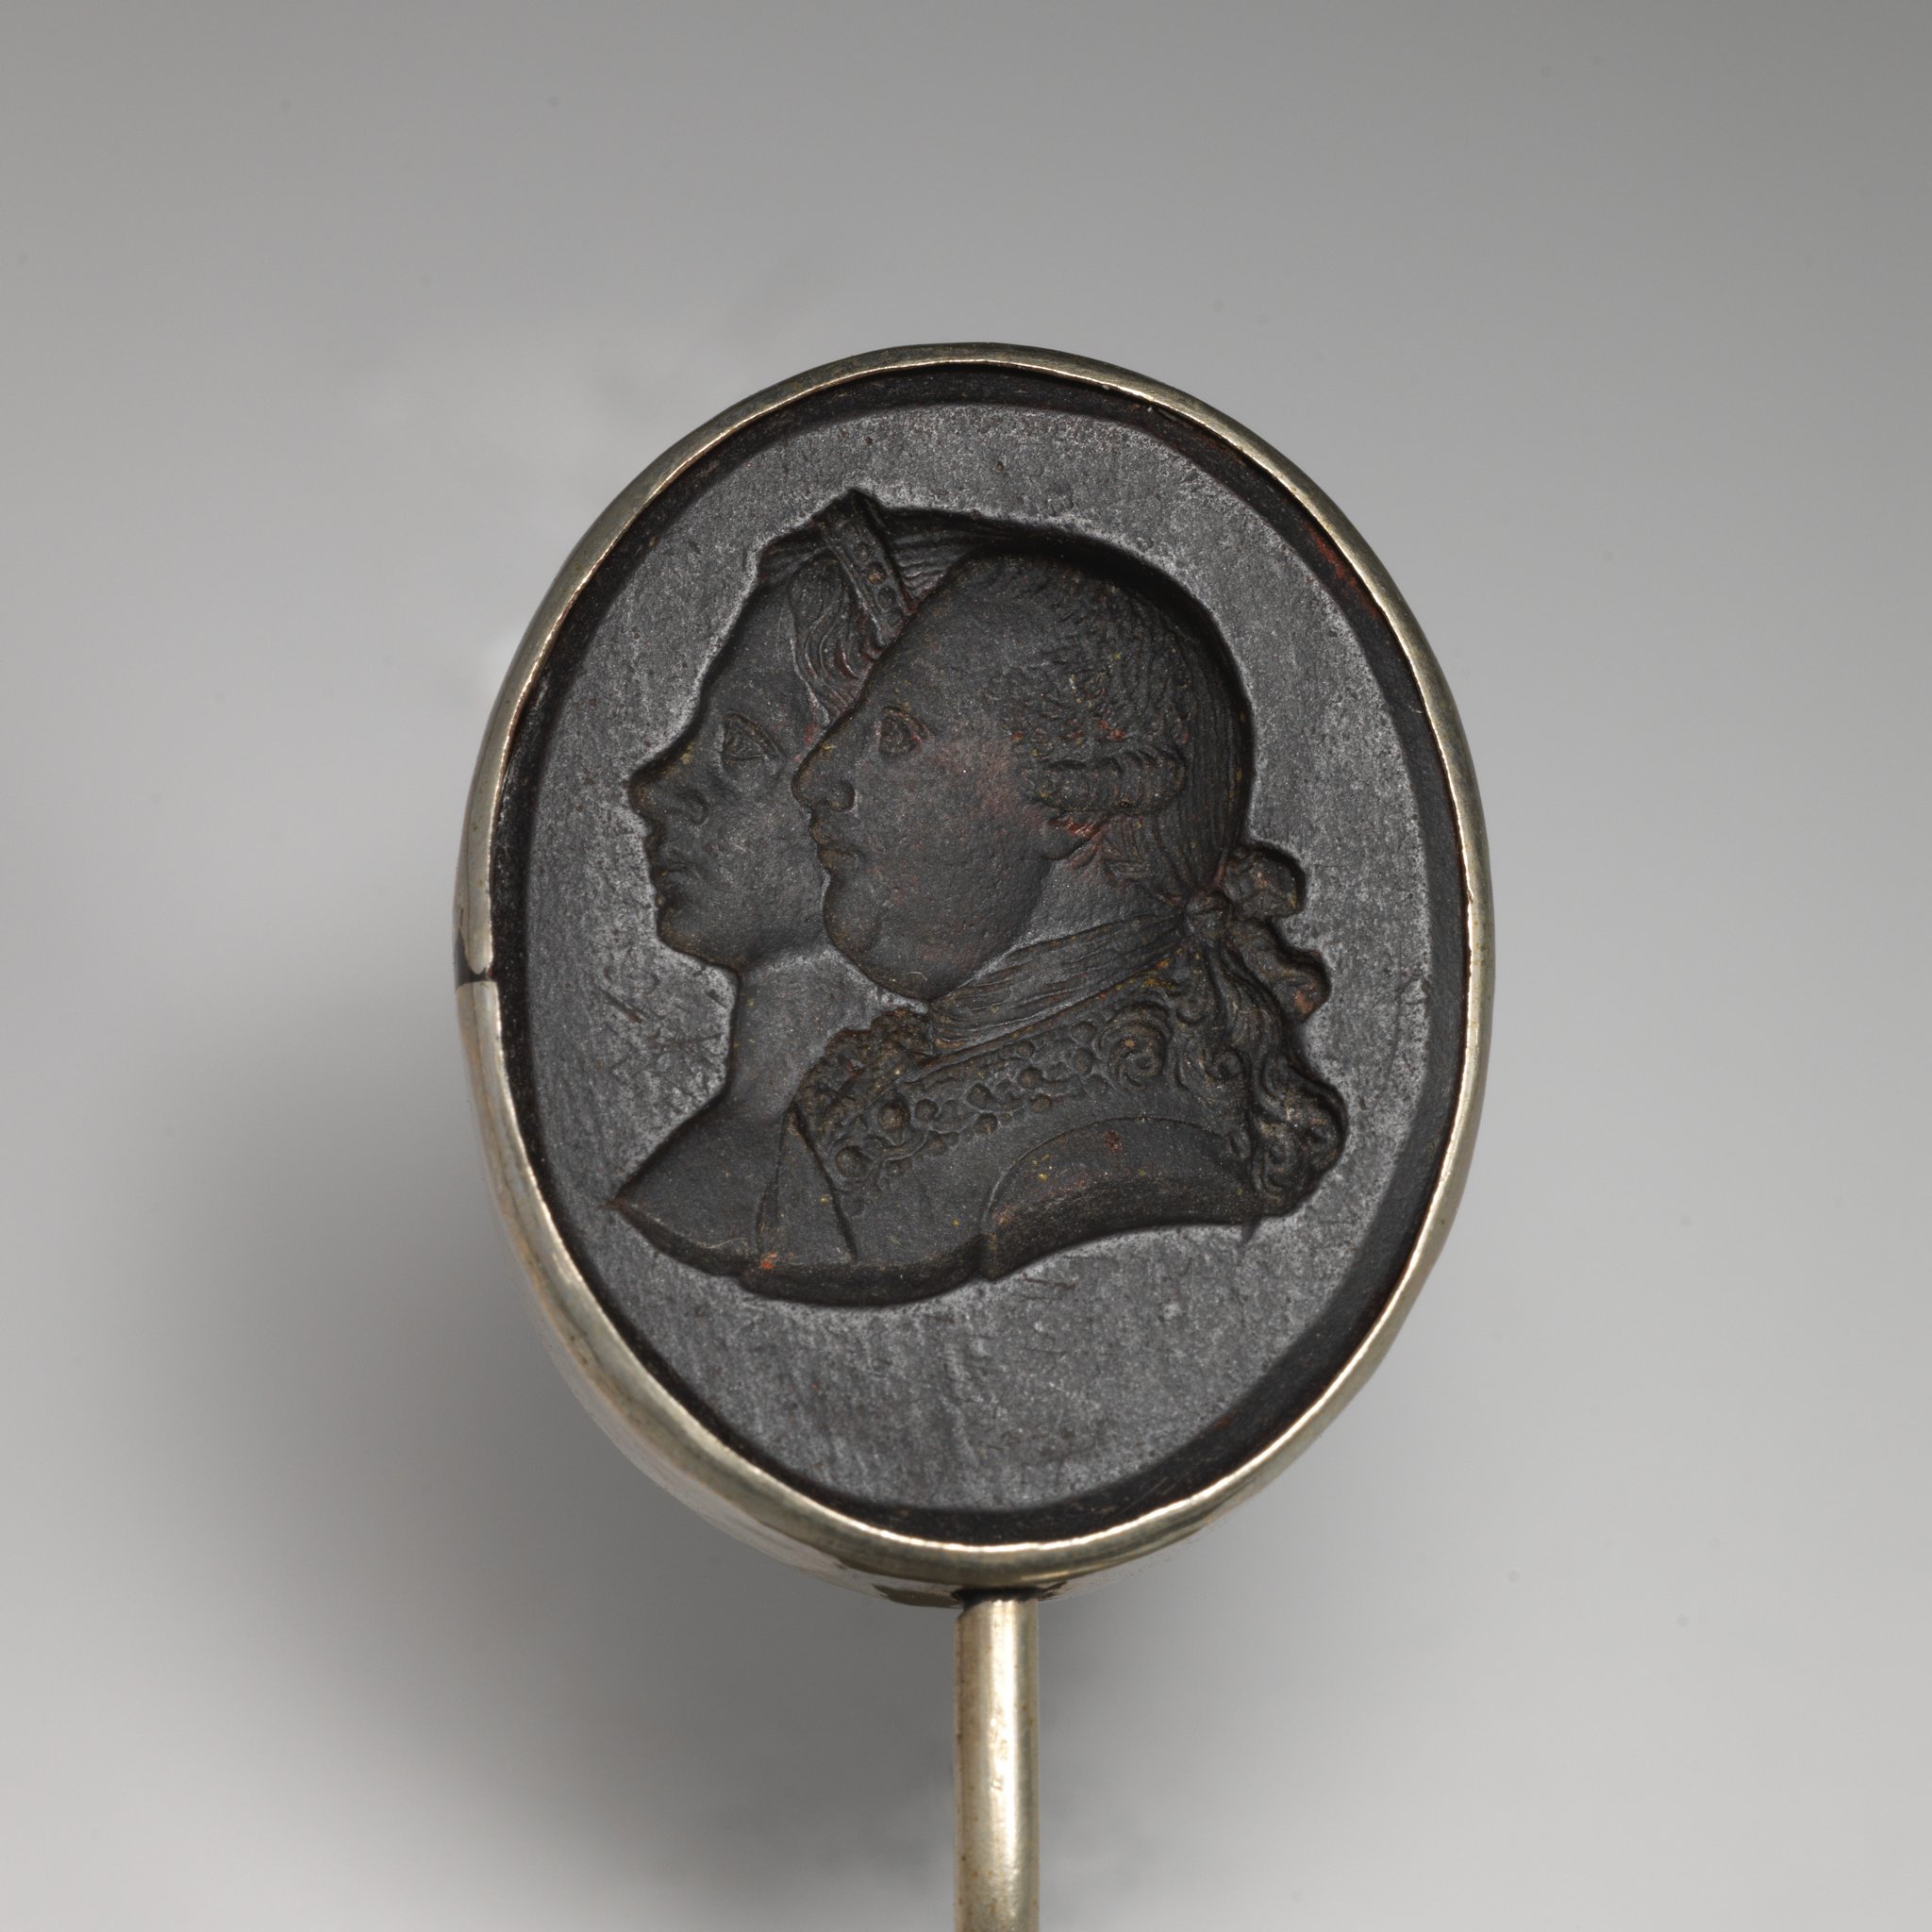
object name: intaglio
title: George III and Queen Charlotte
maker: wedgwood and bentley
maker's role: maker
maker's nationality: british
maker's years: 1769-1780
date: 1780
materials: stone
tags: men,profiles,women